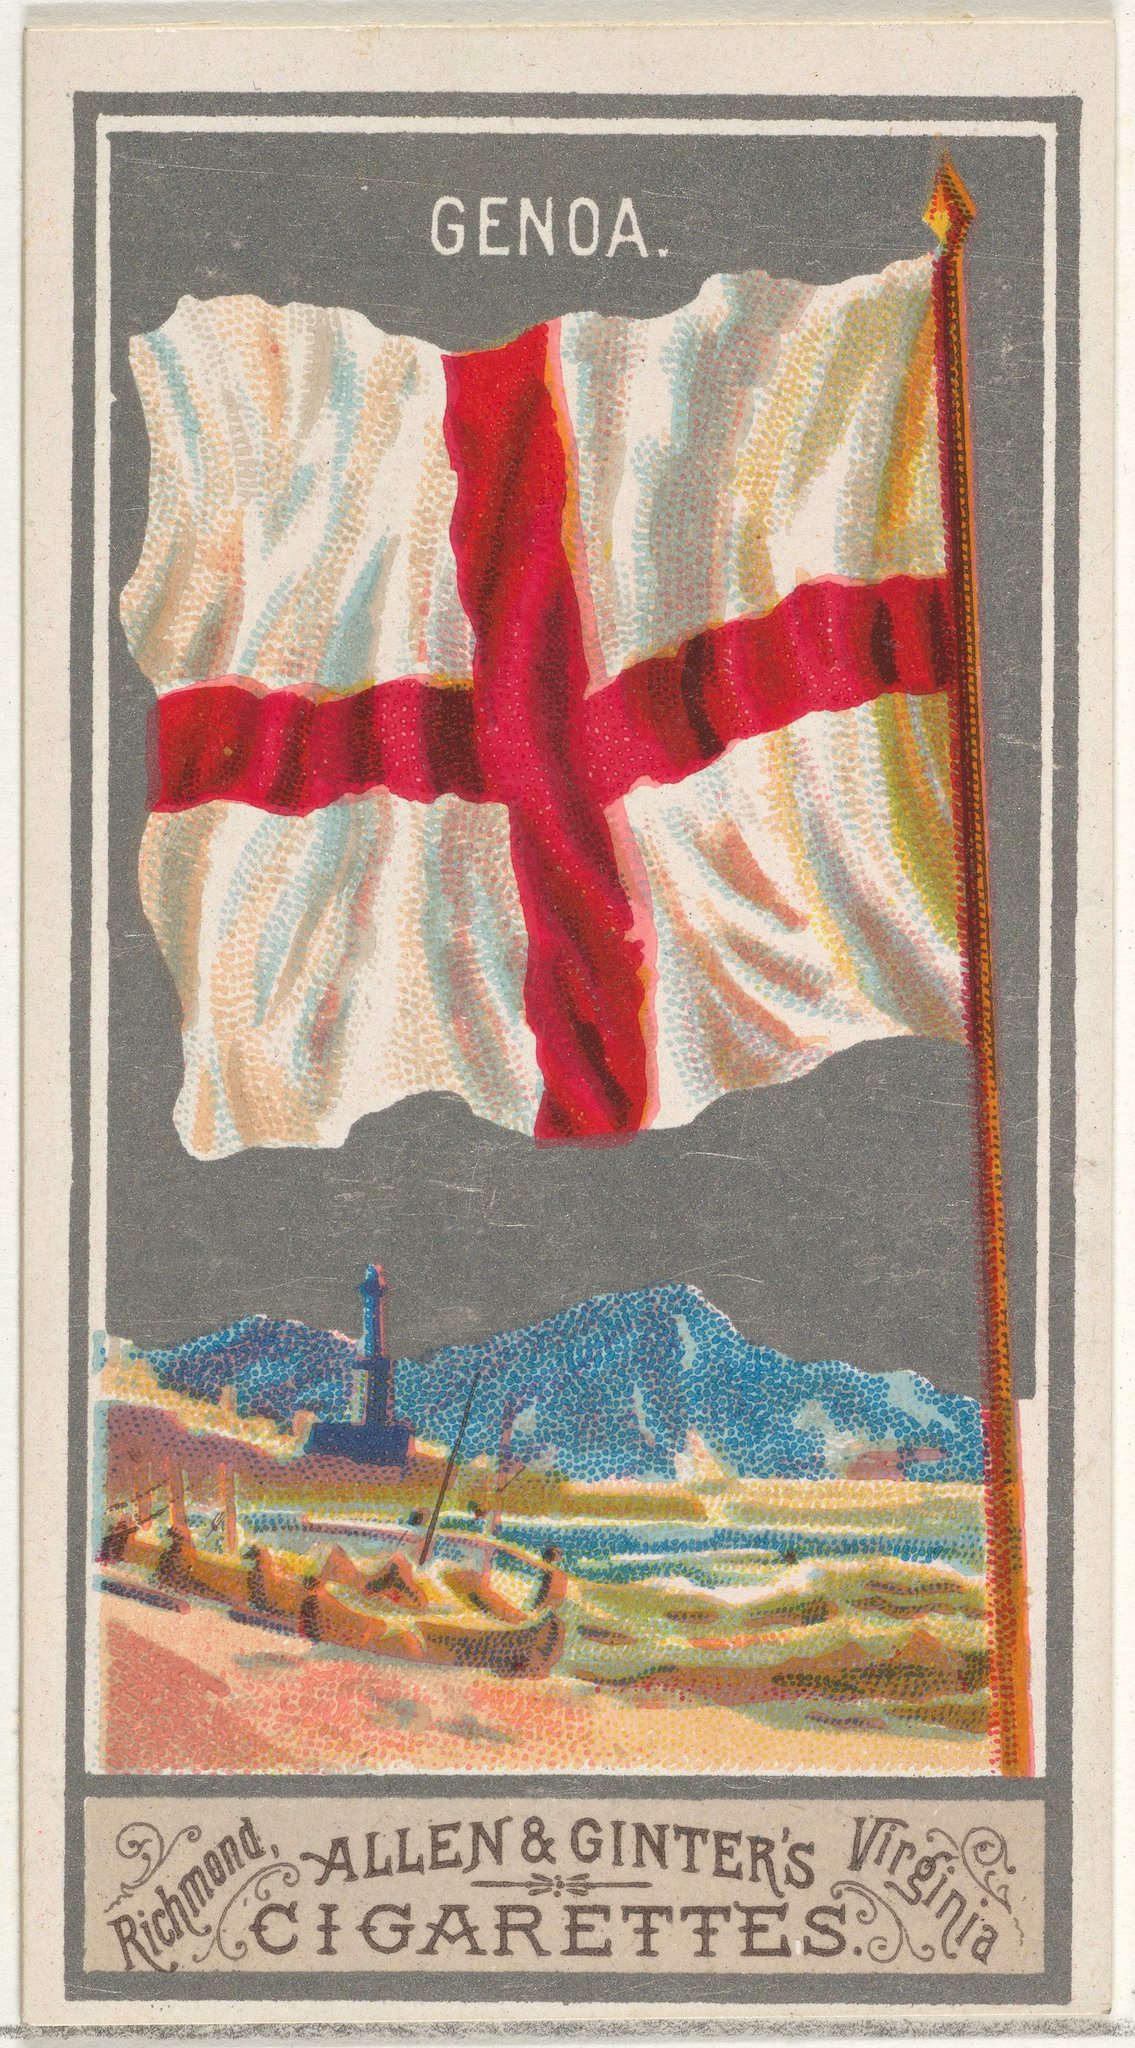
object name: print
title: Genoa, from the City Flags series (N6) for Allen & Ginter Cigarettes Brands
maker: allen & ginter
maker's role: publisher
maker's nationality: american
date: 1887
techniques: color lithograph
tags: flags